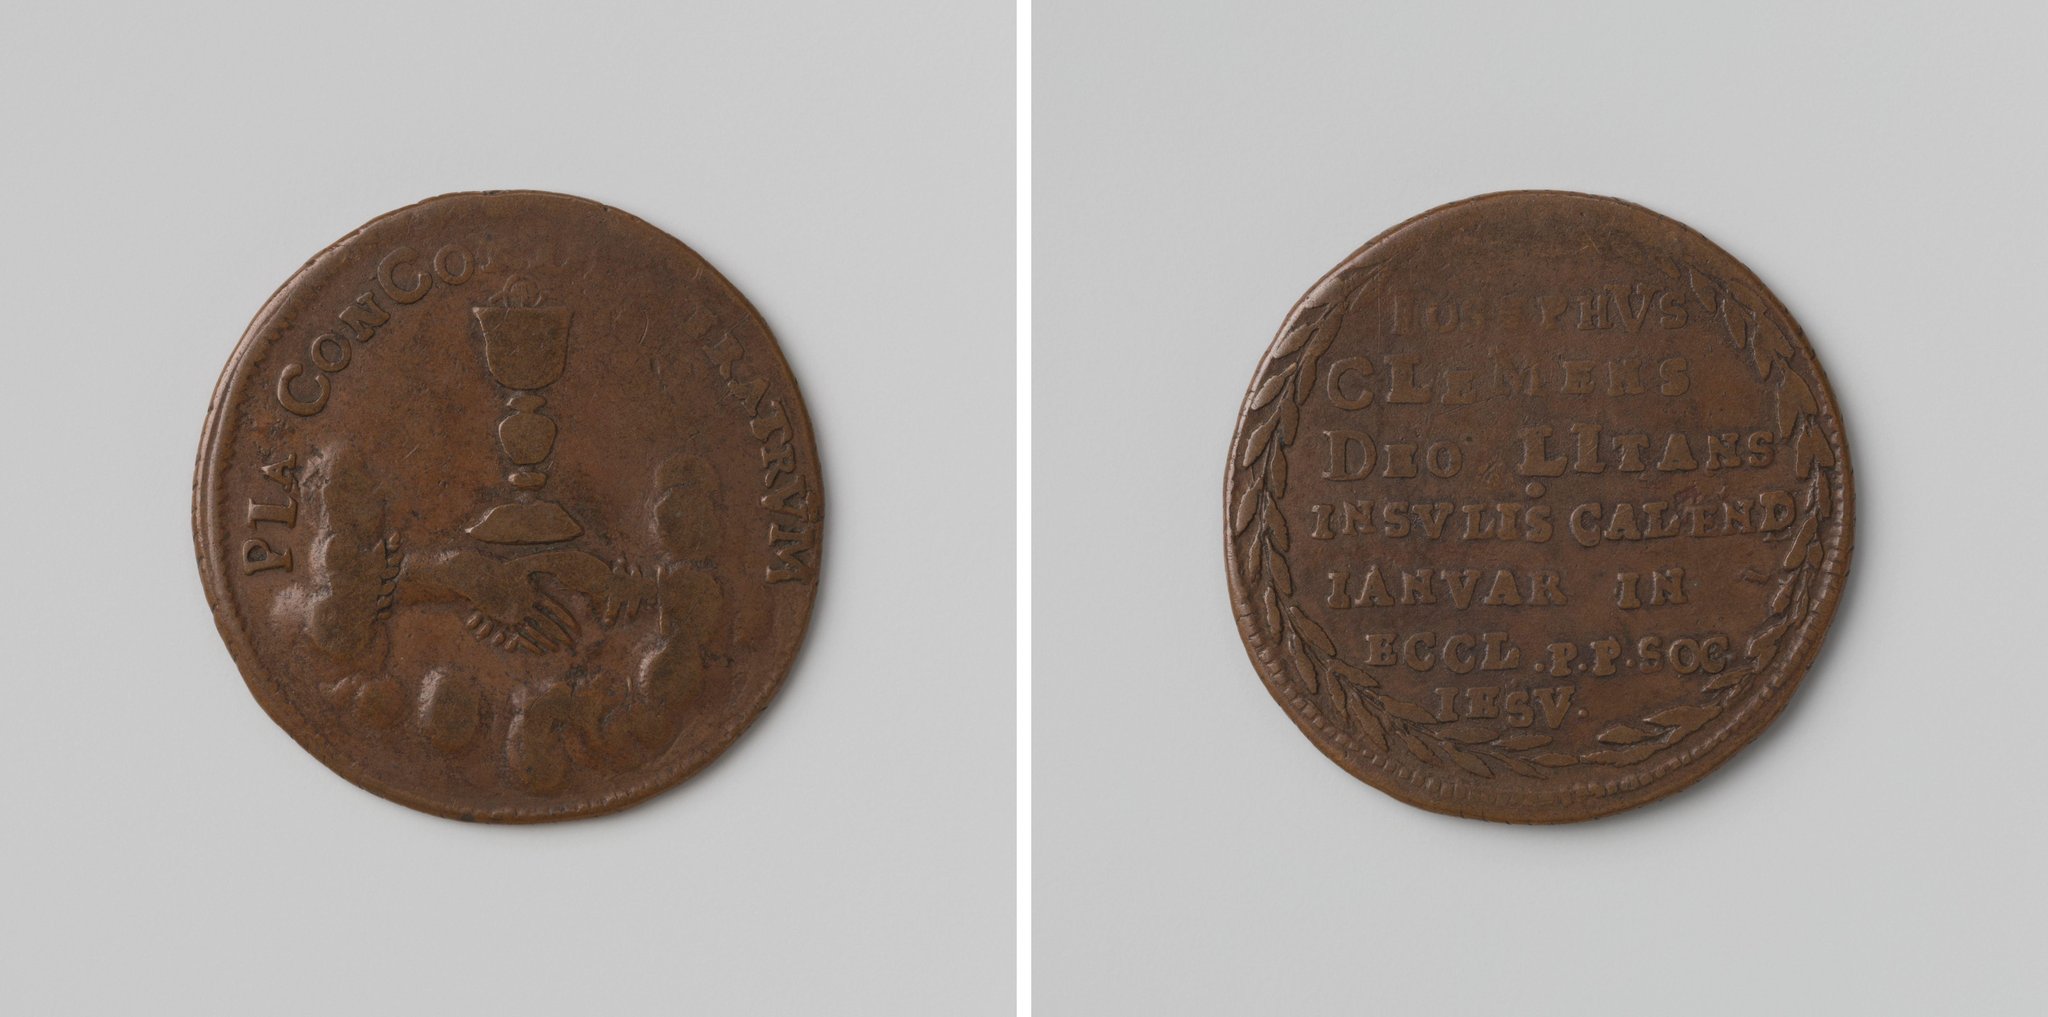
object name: jeton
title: Jozef Klemens, prins-bisschop van Luik draagt in de Jezuietenkerk te Rijssel zijn eerste mis op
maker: Anonymous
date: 1707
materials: copper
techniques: striking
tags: priest, lille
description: Koperen penning. Voorzijde: kelk met hostie boven twee ineen geslagen handen uit wolken binnen omschrift. Keerzijde: opschrift binnen bladerkrans